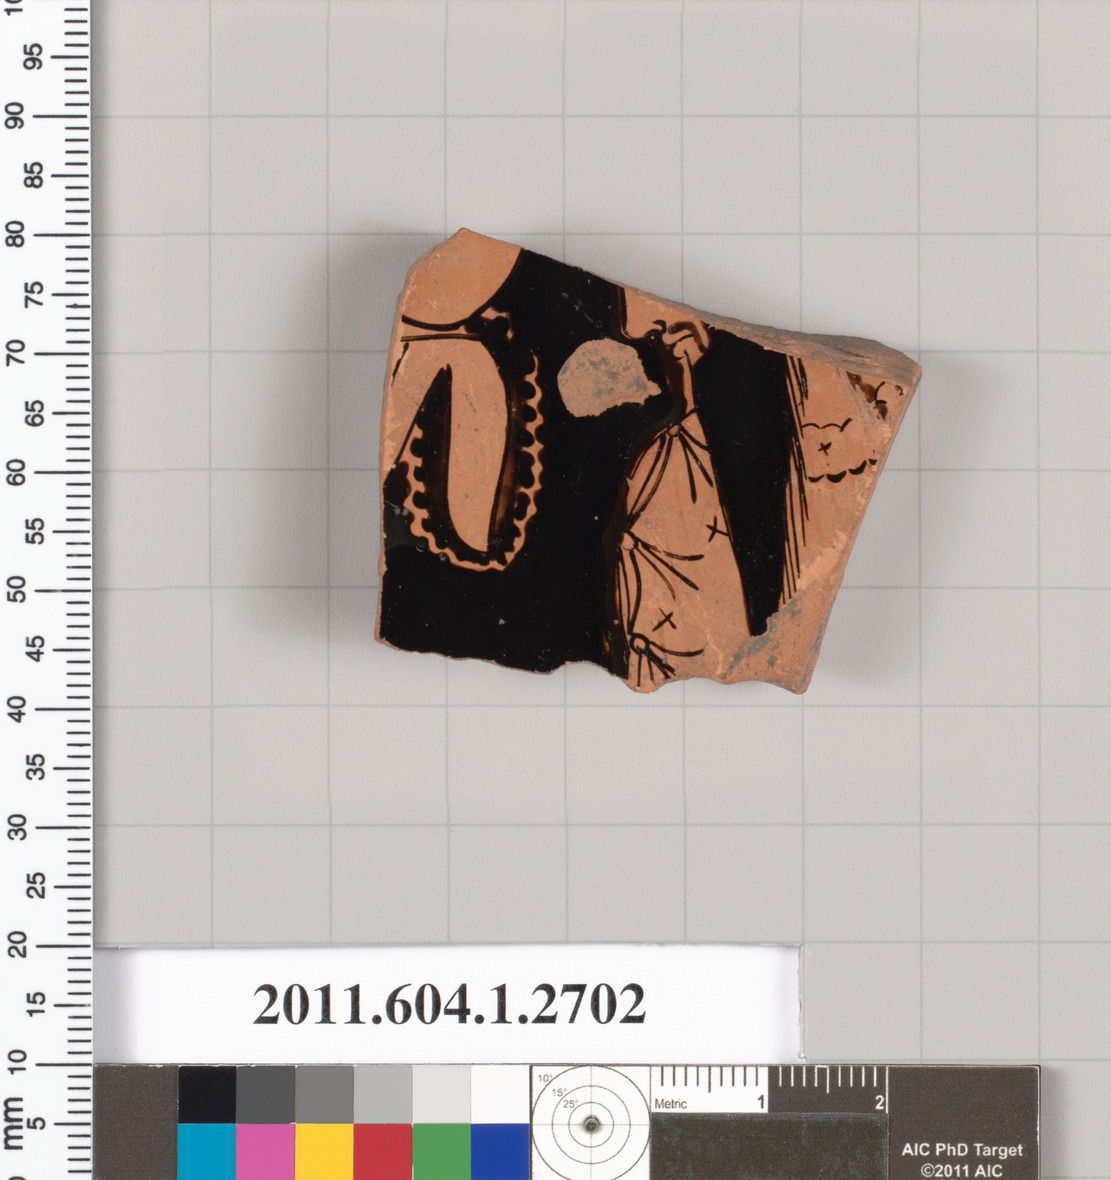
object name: kylix fragment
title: Terracotta fragment of a kylix (drinking cup)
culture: greek, attic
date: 475-451 BCE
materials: terracotta